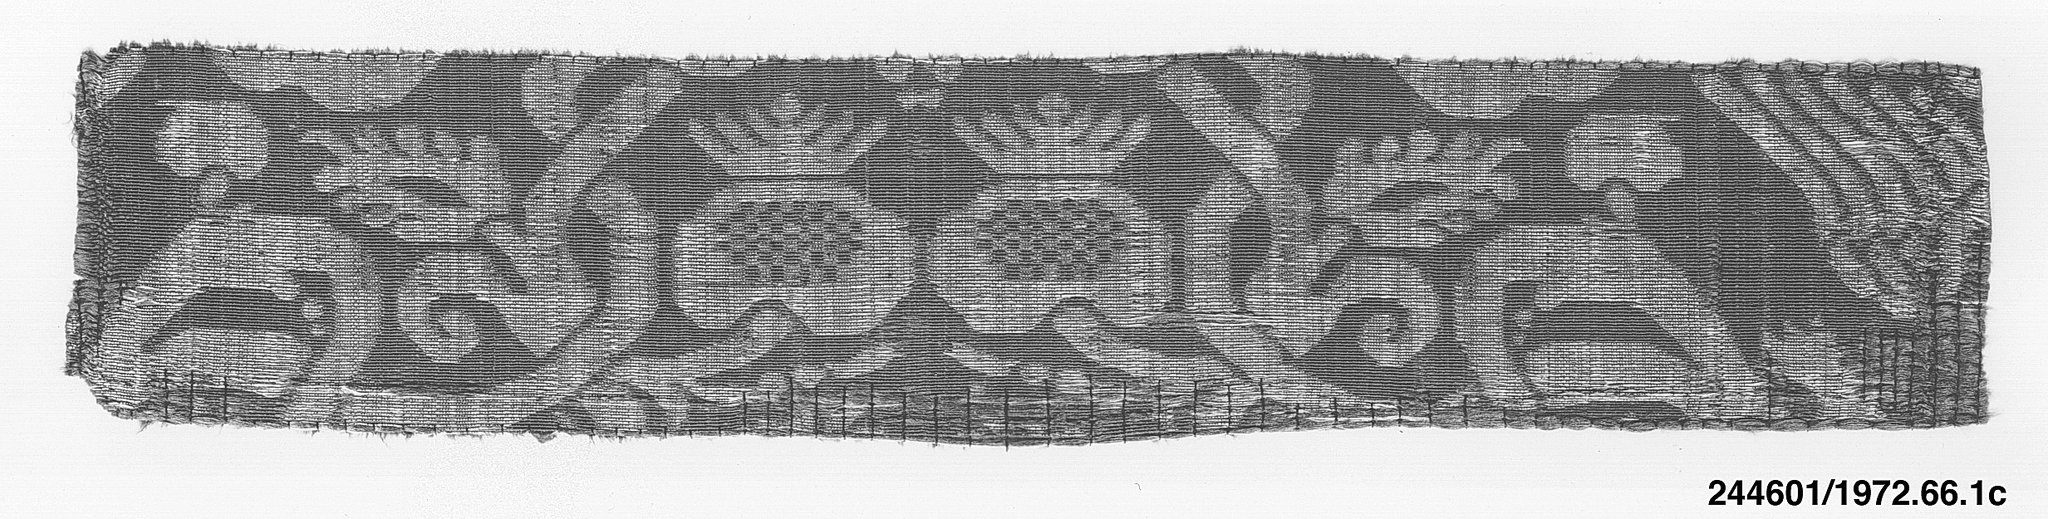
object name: piece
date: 1501-1600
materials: silk